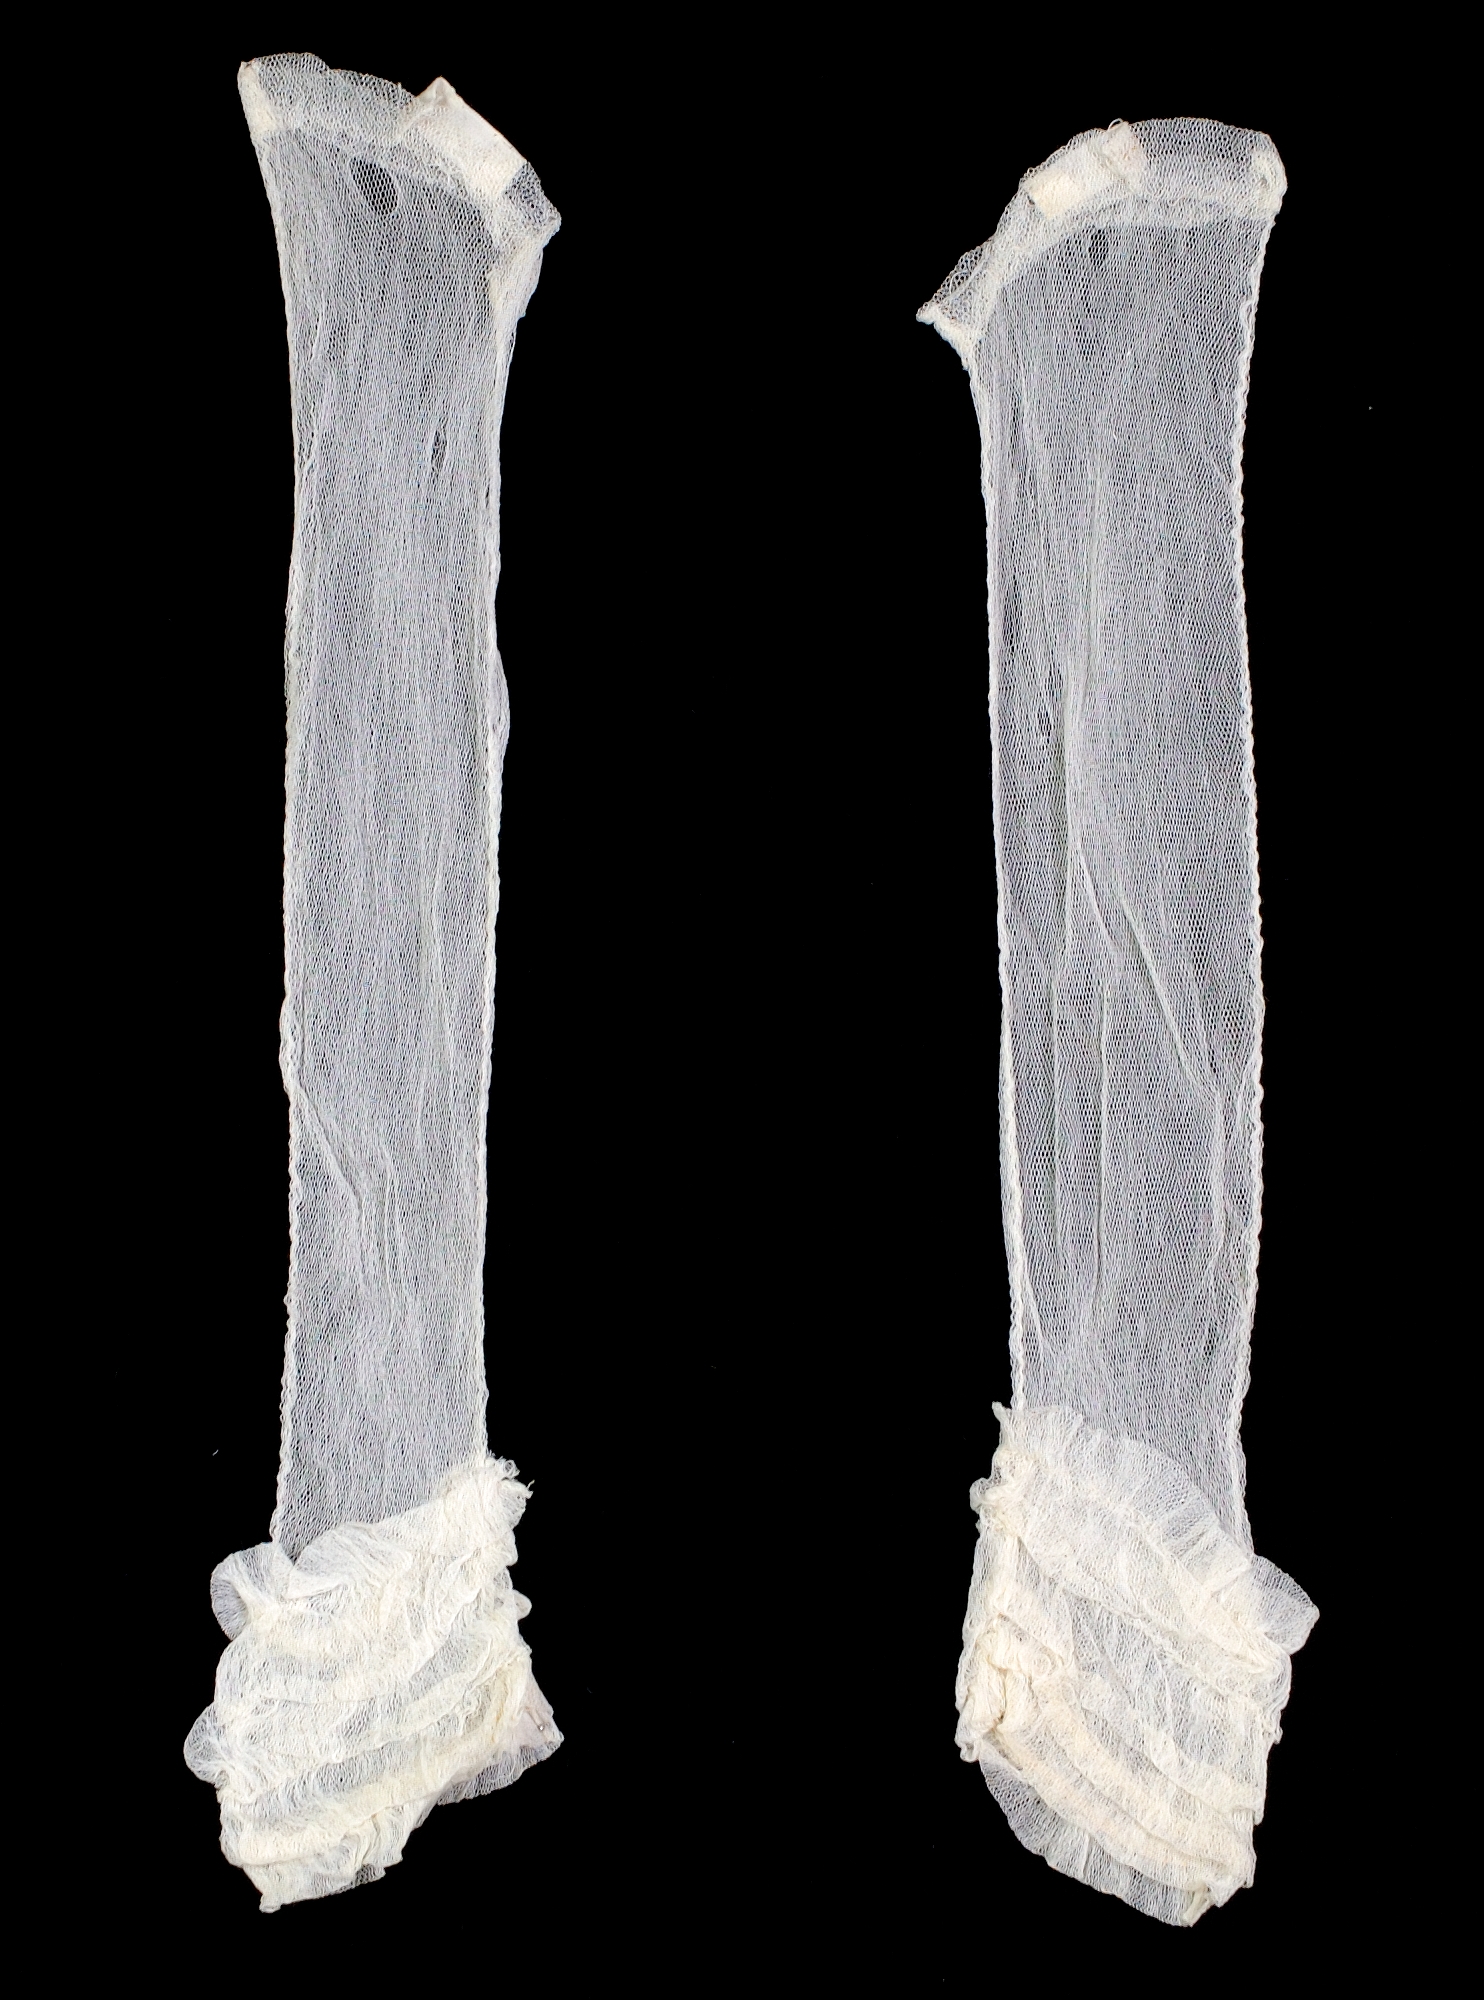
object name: undersleeves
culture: american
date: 1825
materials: silk